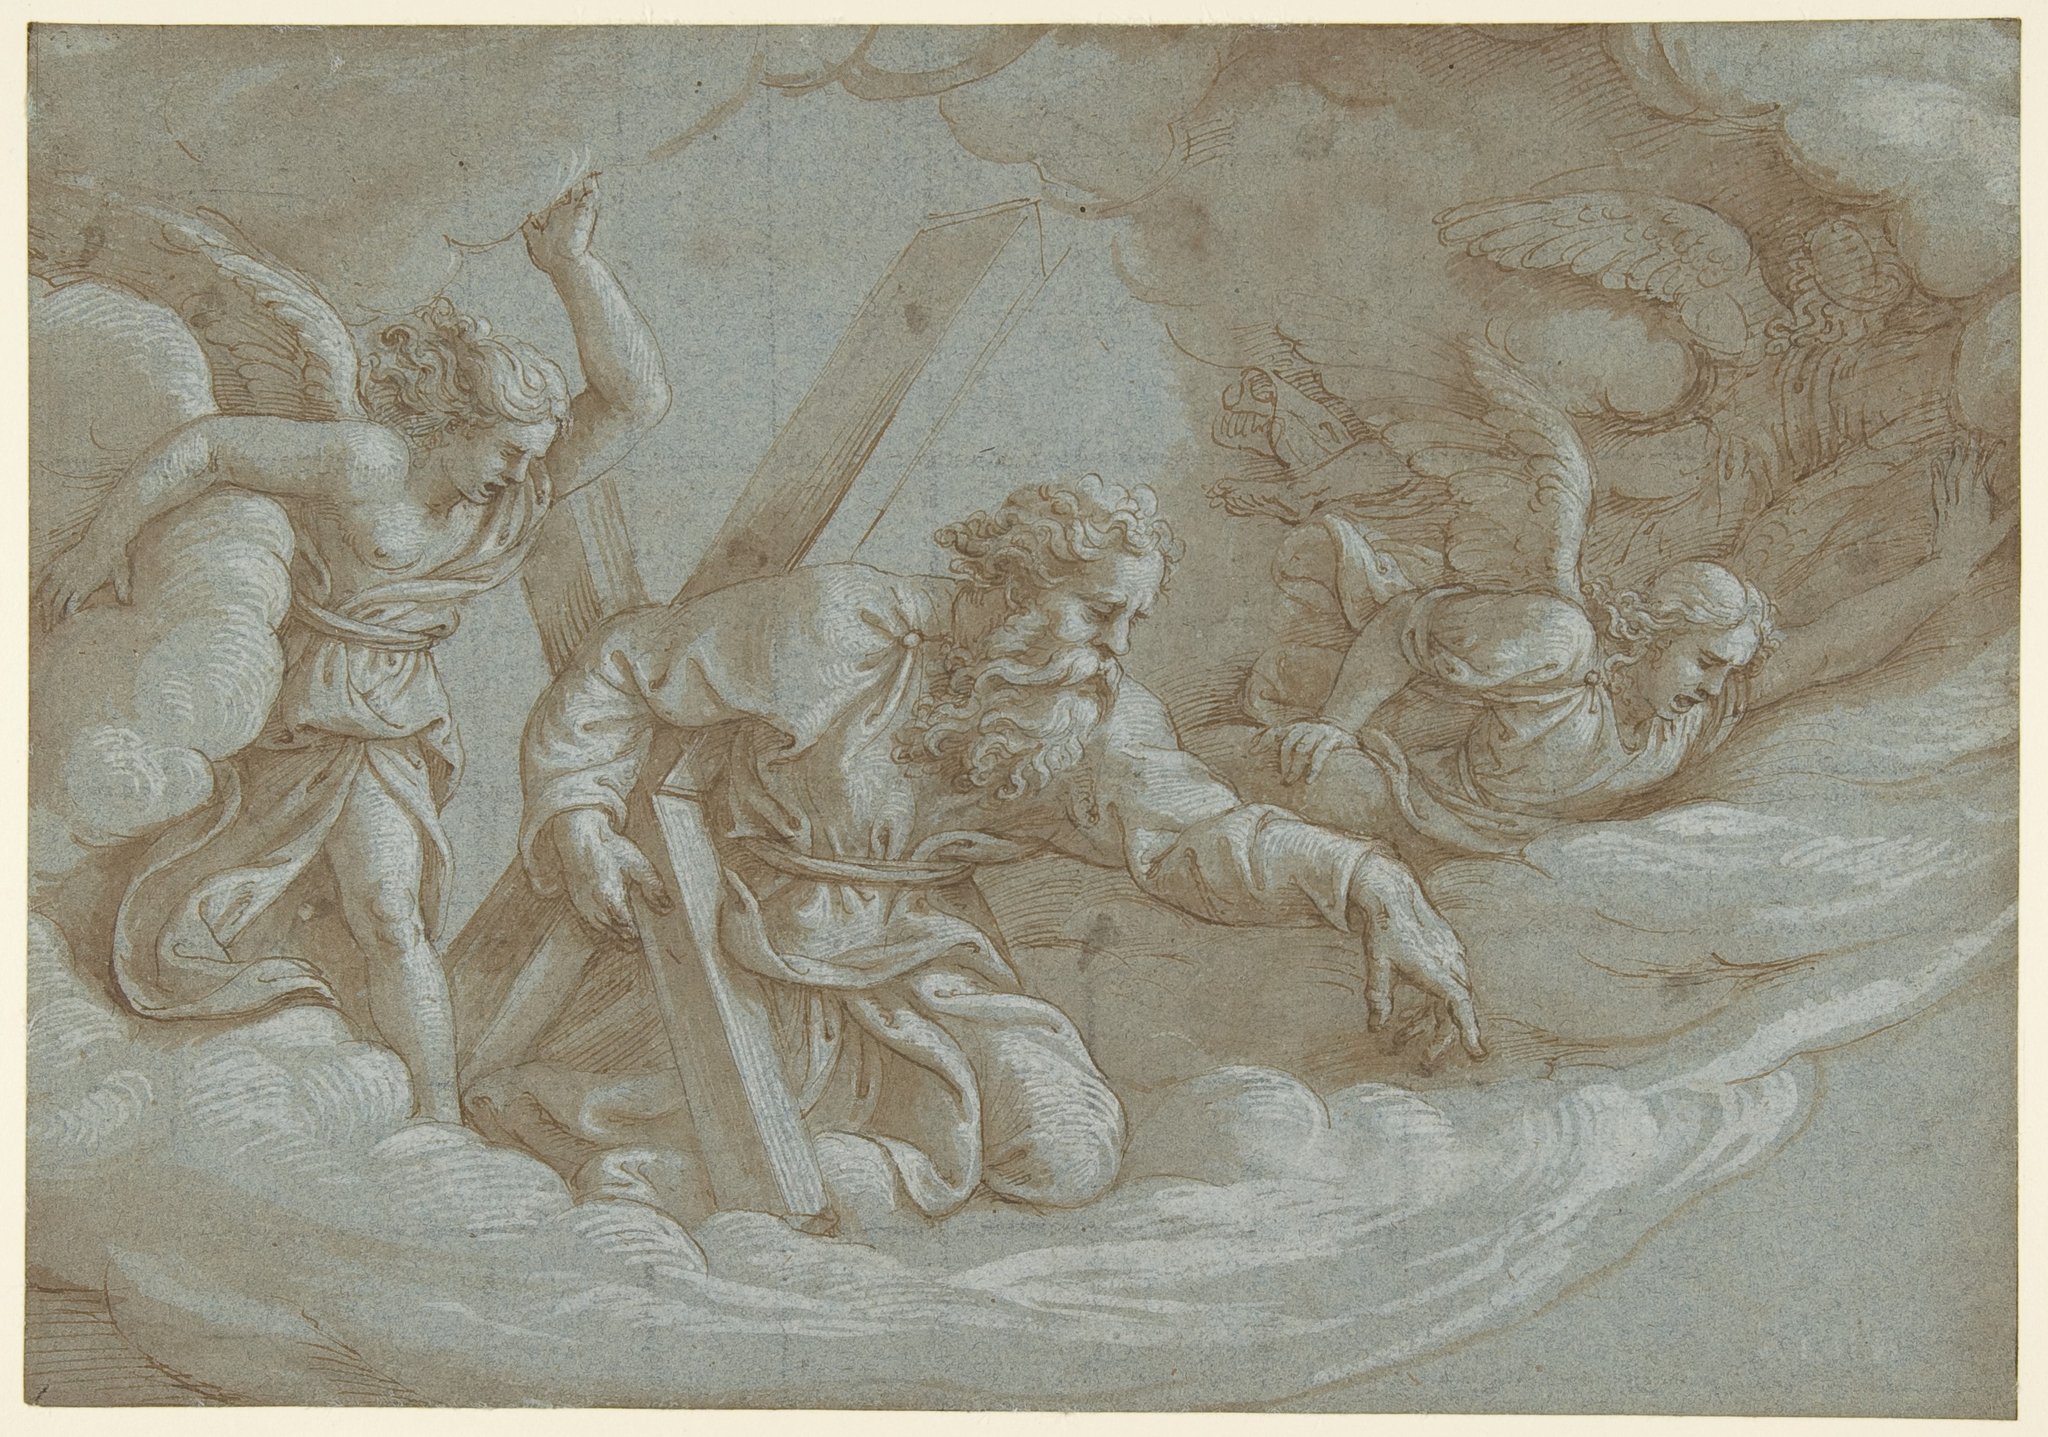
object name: drawing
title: Apparition of Saint Andrew in Glory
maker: giulio romano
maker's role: artist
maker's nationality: italian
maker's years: 1499-1546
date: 1499-1546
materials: chalk, gouache, ink, paper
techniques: brush, highlighting, pen, drawing, wash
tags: angels,cross,saints